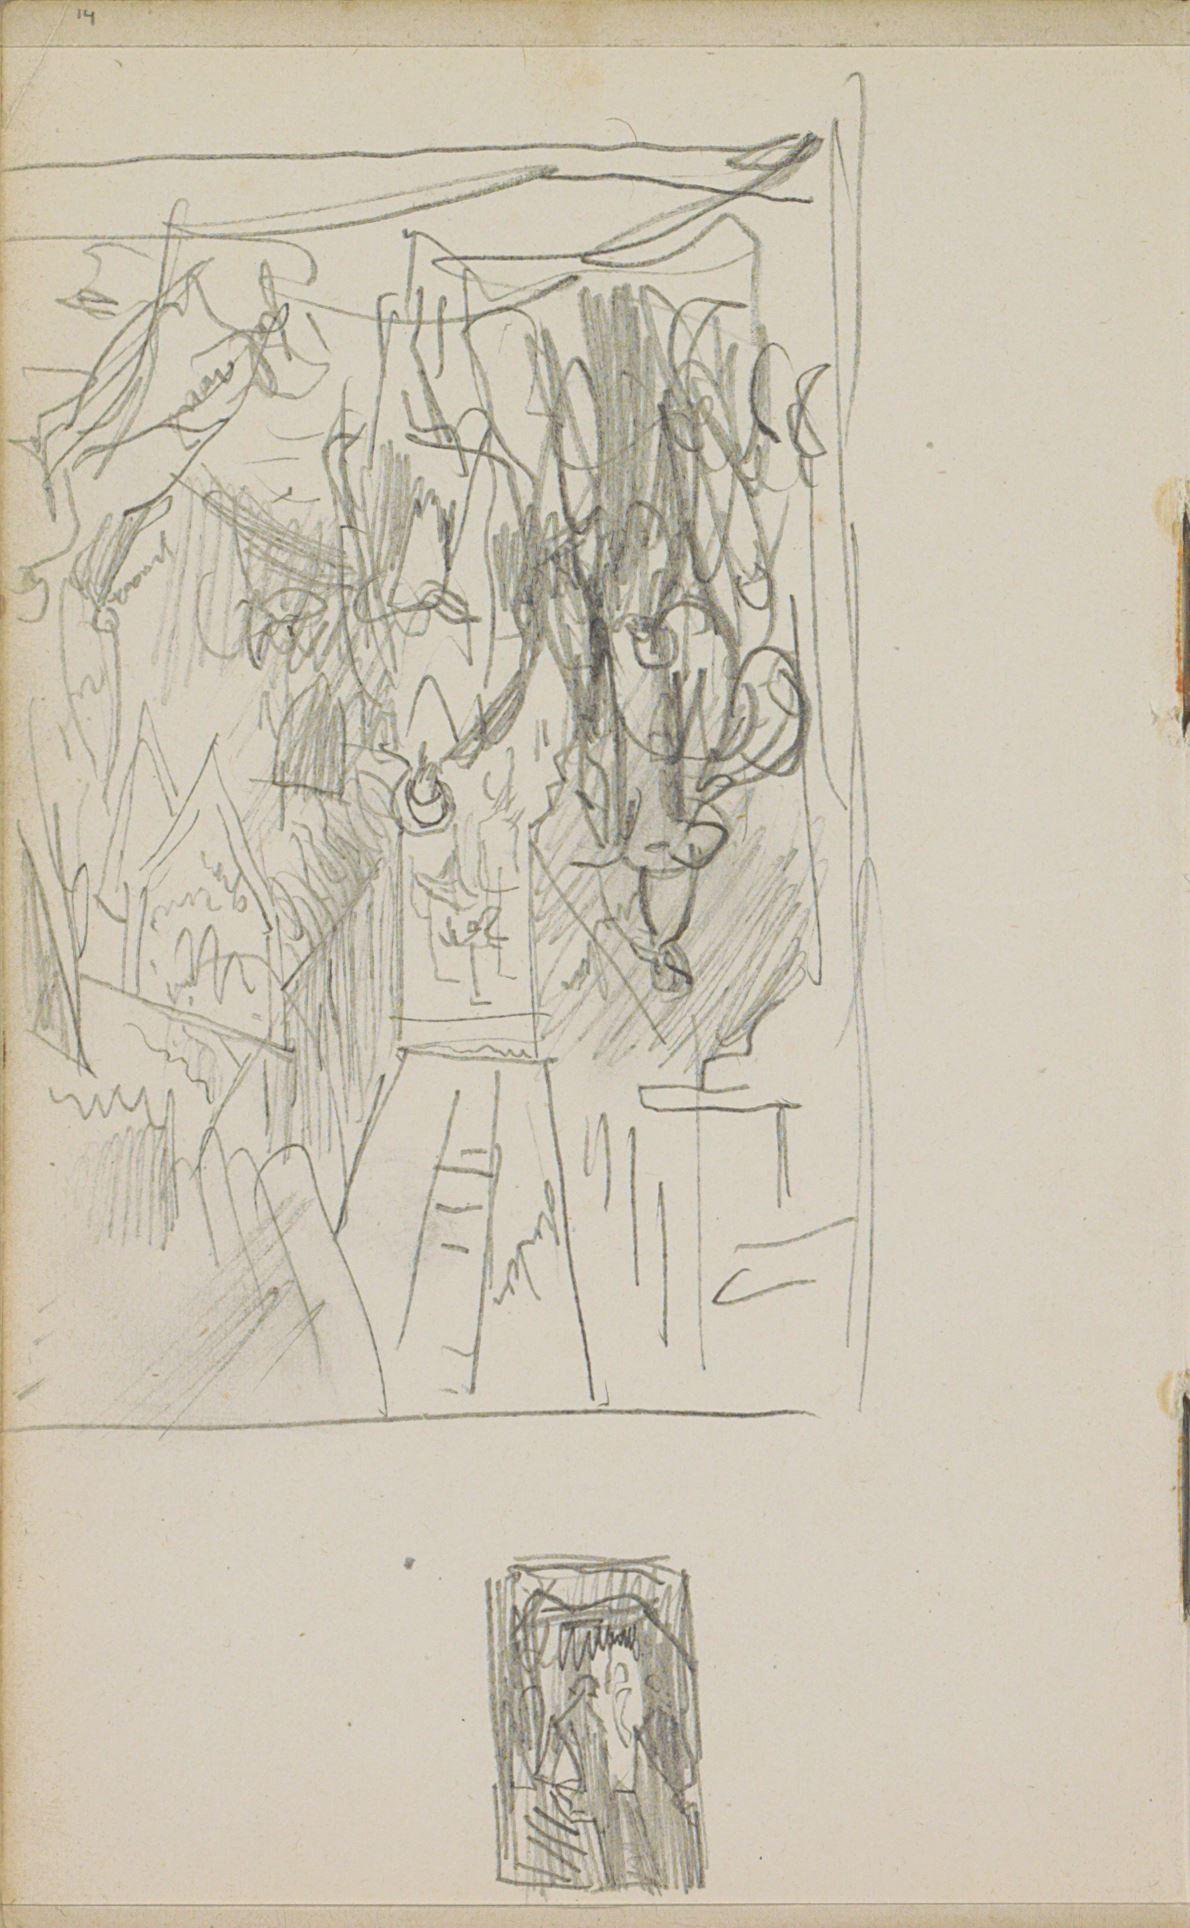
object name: sketchbook leaf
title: Straat met een figuur op een ezel en een kameel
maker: marius bauer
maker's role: draughtsman, print maker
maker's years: 1867-1932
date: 1904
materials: paper, pencil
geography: cairo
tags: riding a horse, ass, or mule; rider, horseman, hoofed animals: camel, street (+ city(-scape) with figures, staffage)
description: Vermoedelijk een straat in Caïro. Pagina 14 uit een schetsboek met 56 bladen.